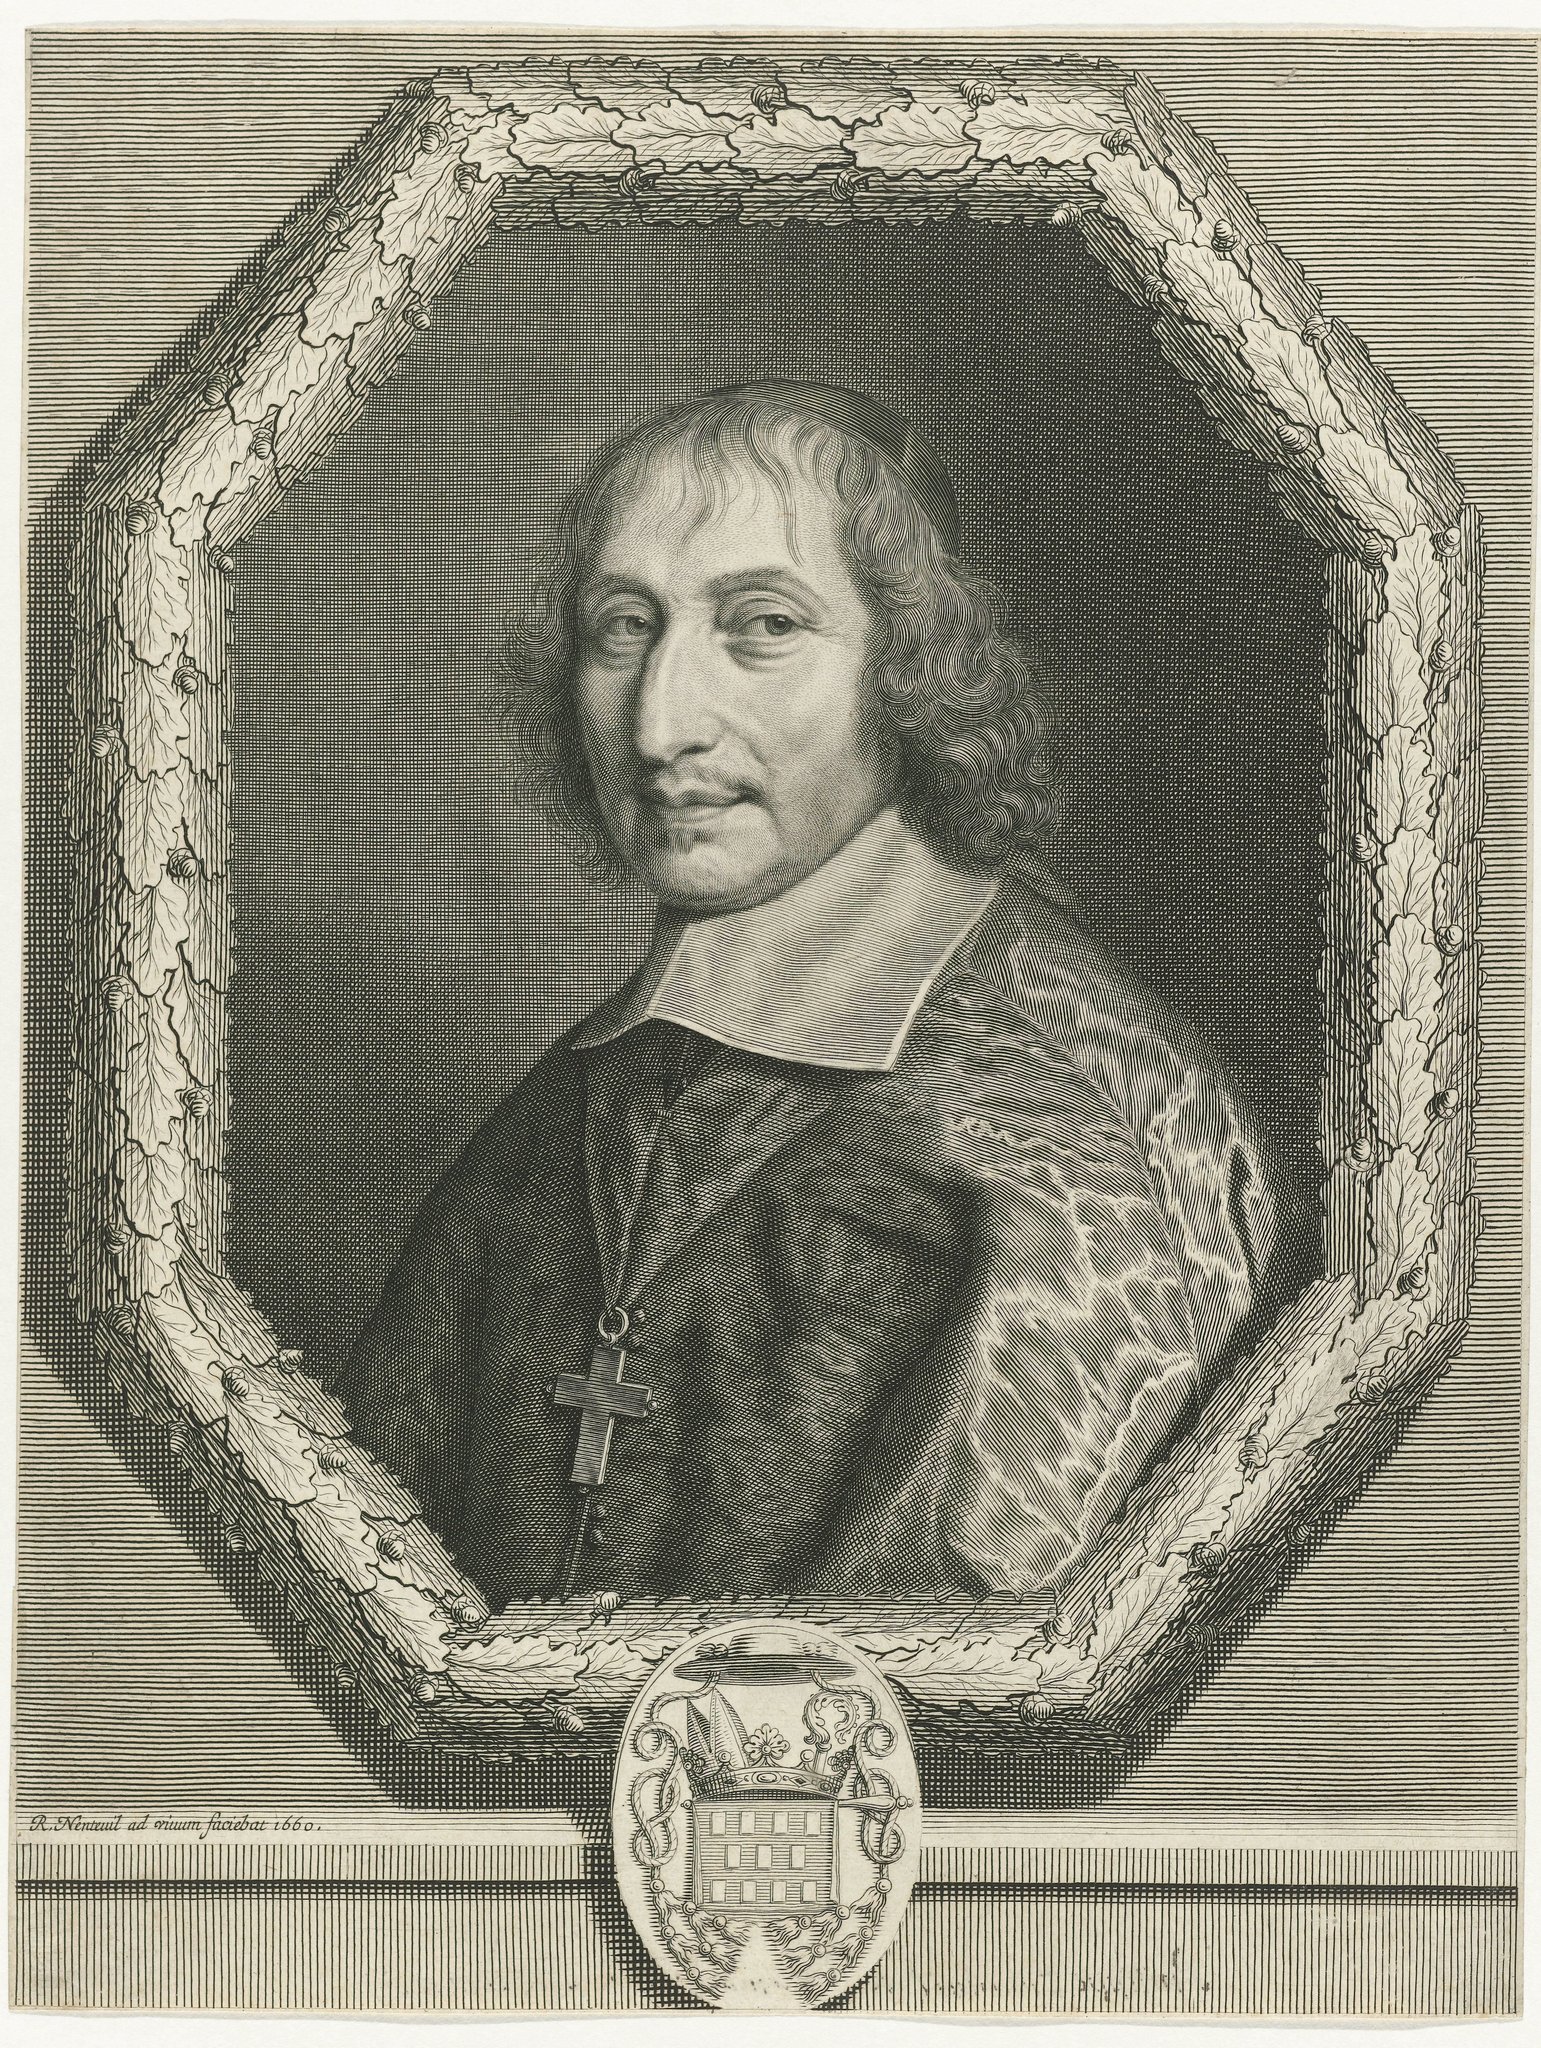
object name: print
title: Portret van Philibert Emmanuel de Beaumanoir de Lavardin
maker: robert nanteuil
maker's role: print maker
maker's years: 1623-1678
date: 1660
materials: paper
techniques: engraving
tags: bisschop, philibert emmanuel de beaumanoir de lavardin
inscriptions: date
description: Buste naar links, in octagonale lijst met middenonder zijn wapen.